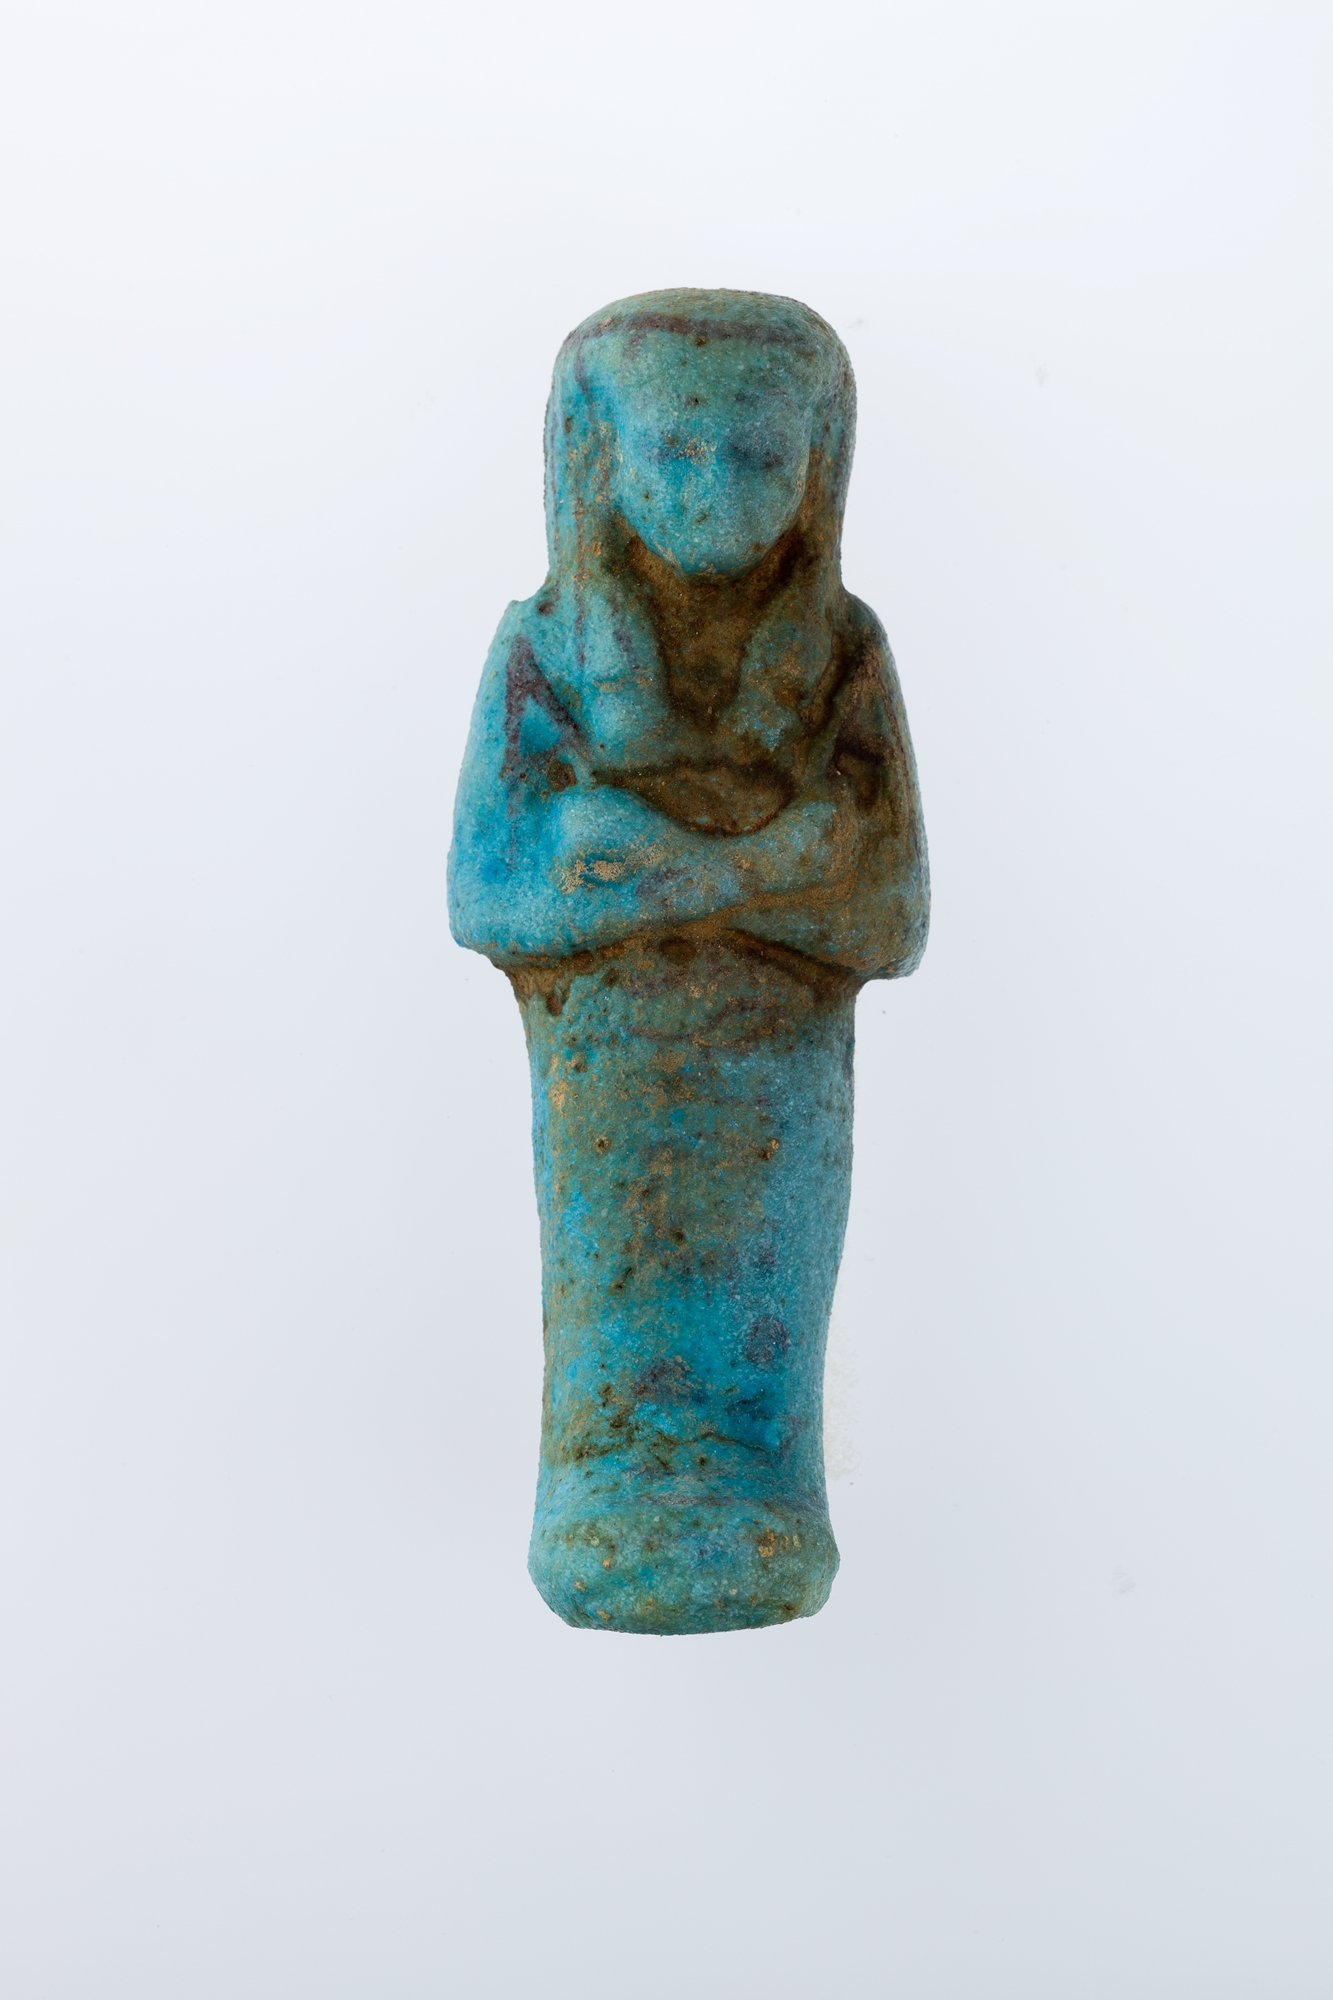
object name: shabti, henettawy c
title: Worker Shabti of Henettawy (C), Daughter of Isetemkheb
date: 990-970 BCE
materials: faience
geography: egypt